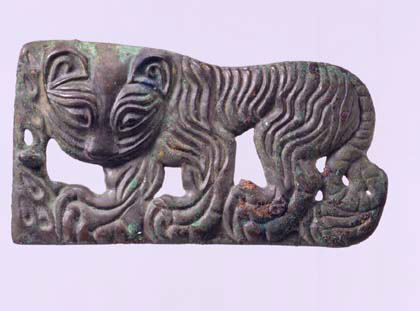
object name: belt buckle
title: Belt buckle with walking tiger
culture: north chinese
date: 300-201 BCE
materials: bronze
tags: tigers